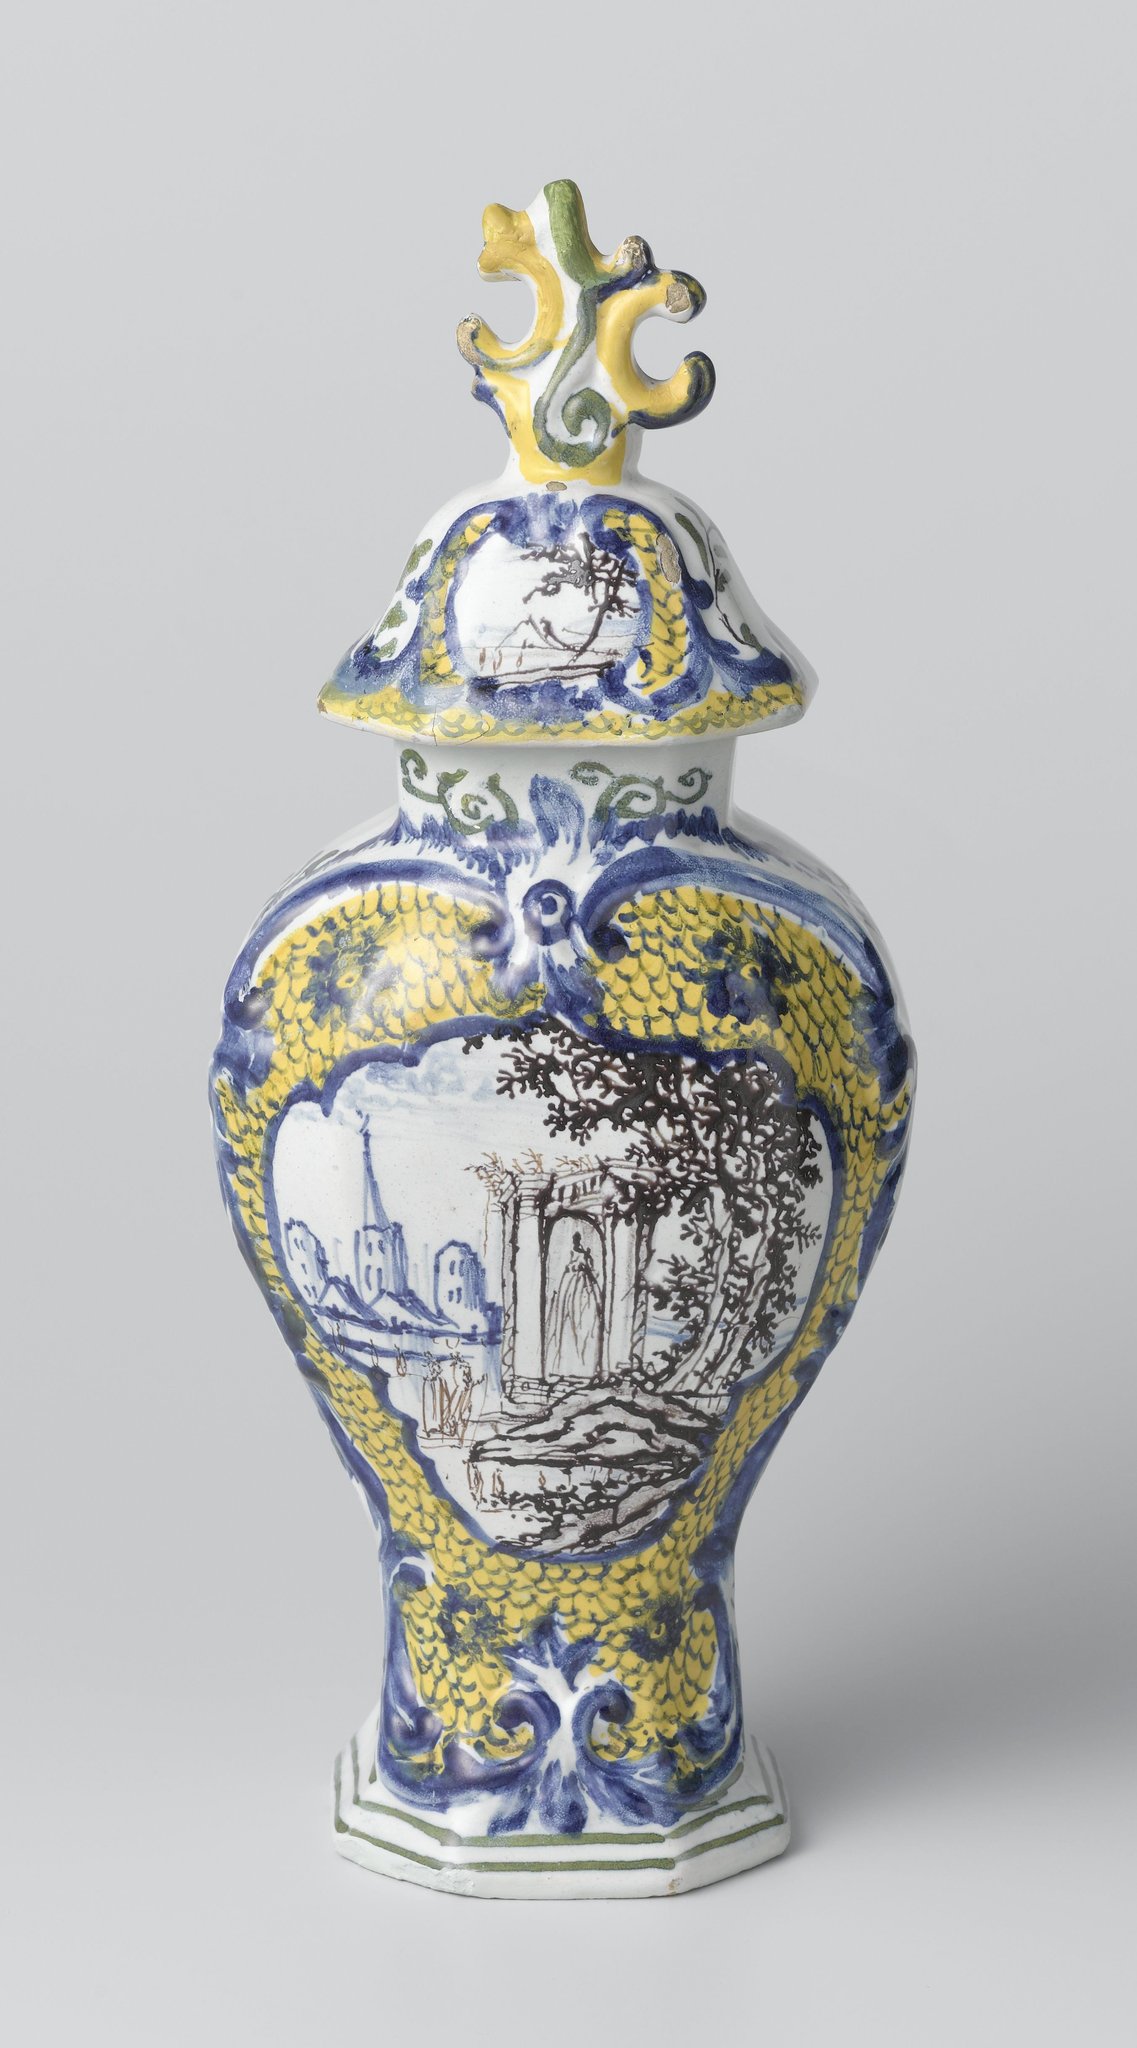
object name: kaststel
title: Deksel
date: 1780-1820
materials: faience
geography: delft